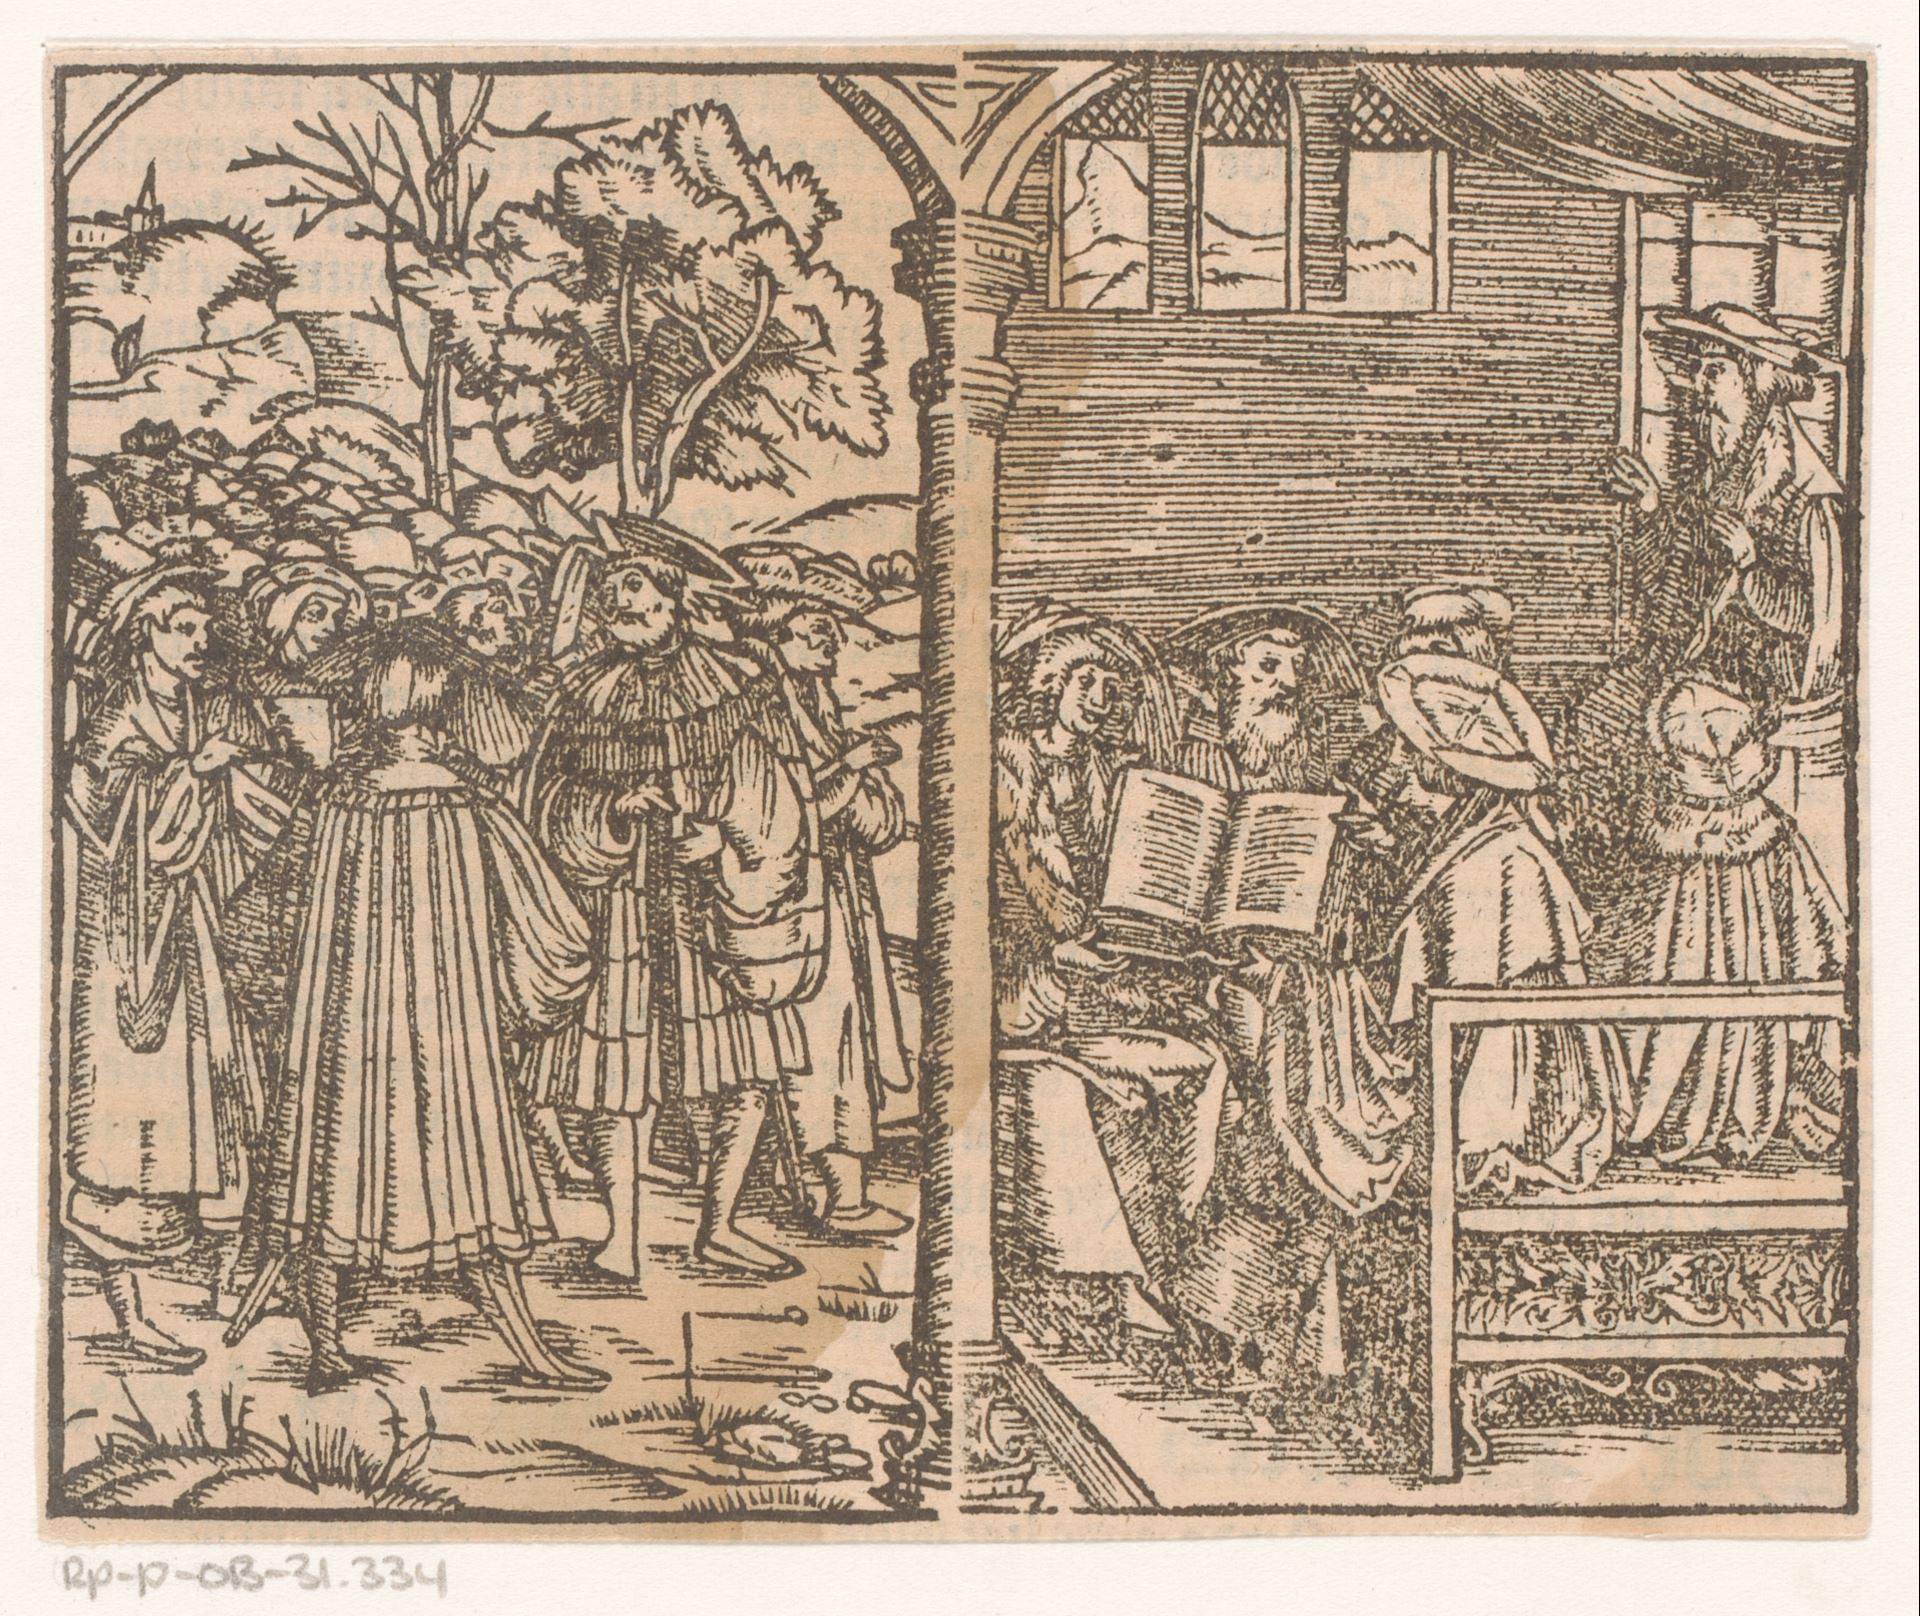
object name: print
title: Links een menigte en rechts een man zittend op een troon omringd door andere zittende mannen met een boek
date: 1541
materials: paper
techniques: letterpress printing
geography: antwerp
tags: adult man (+ sitting), throne, book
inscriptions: collector's mark: Lugt 2228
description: Prent uit: Livius, Titus. De roemsche historie oft gesten. Antwerpen: Jan Gymnius, 1541.